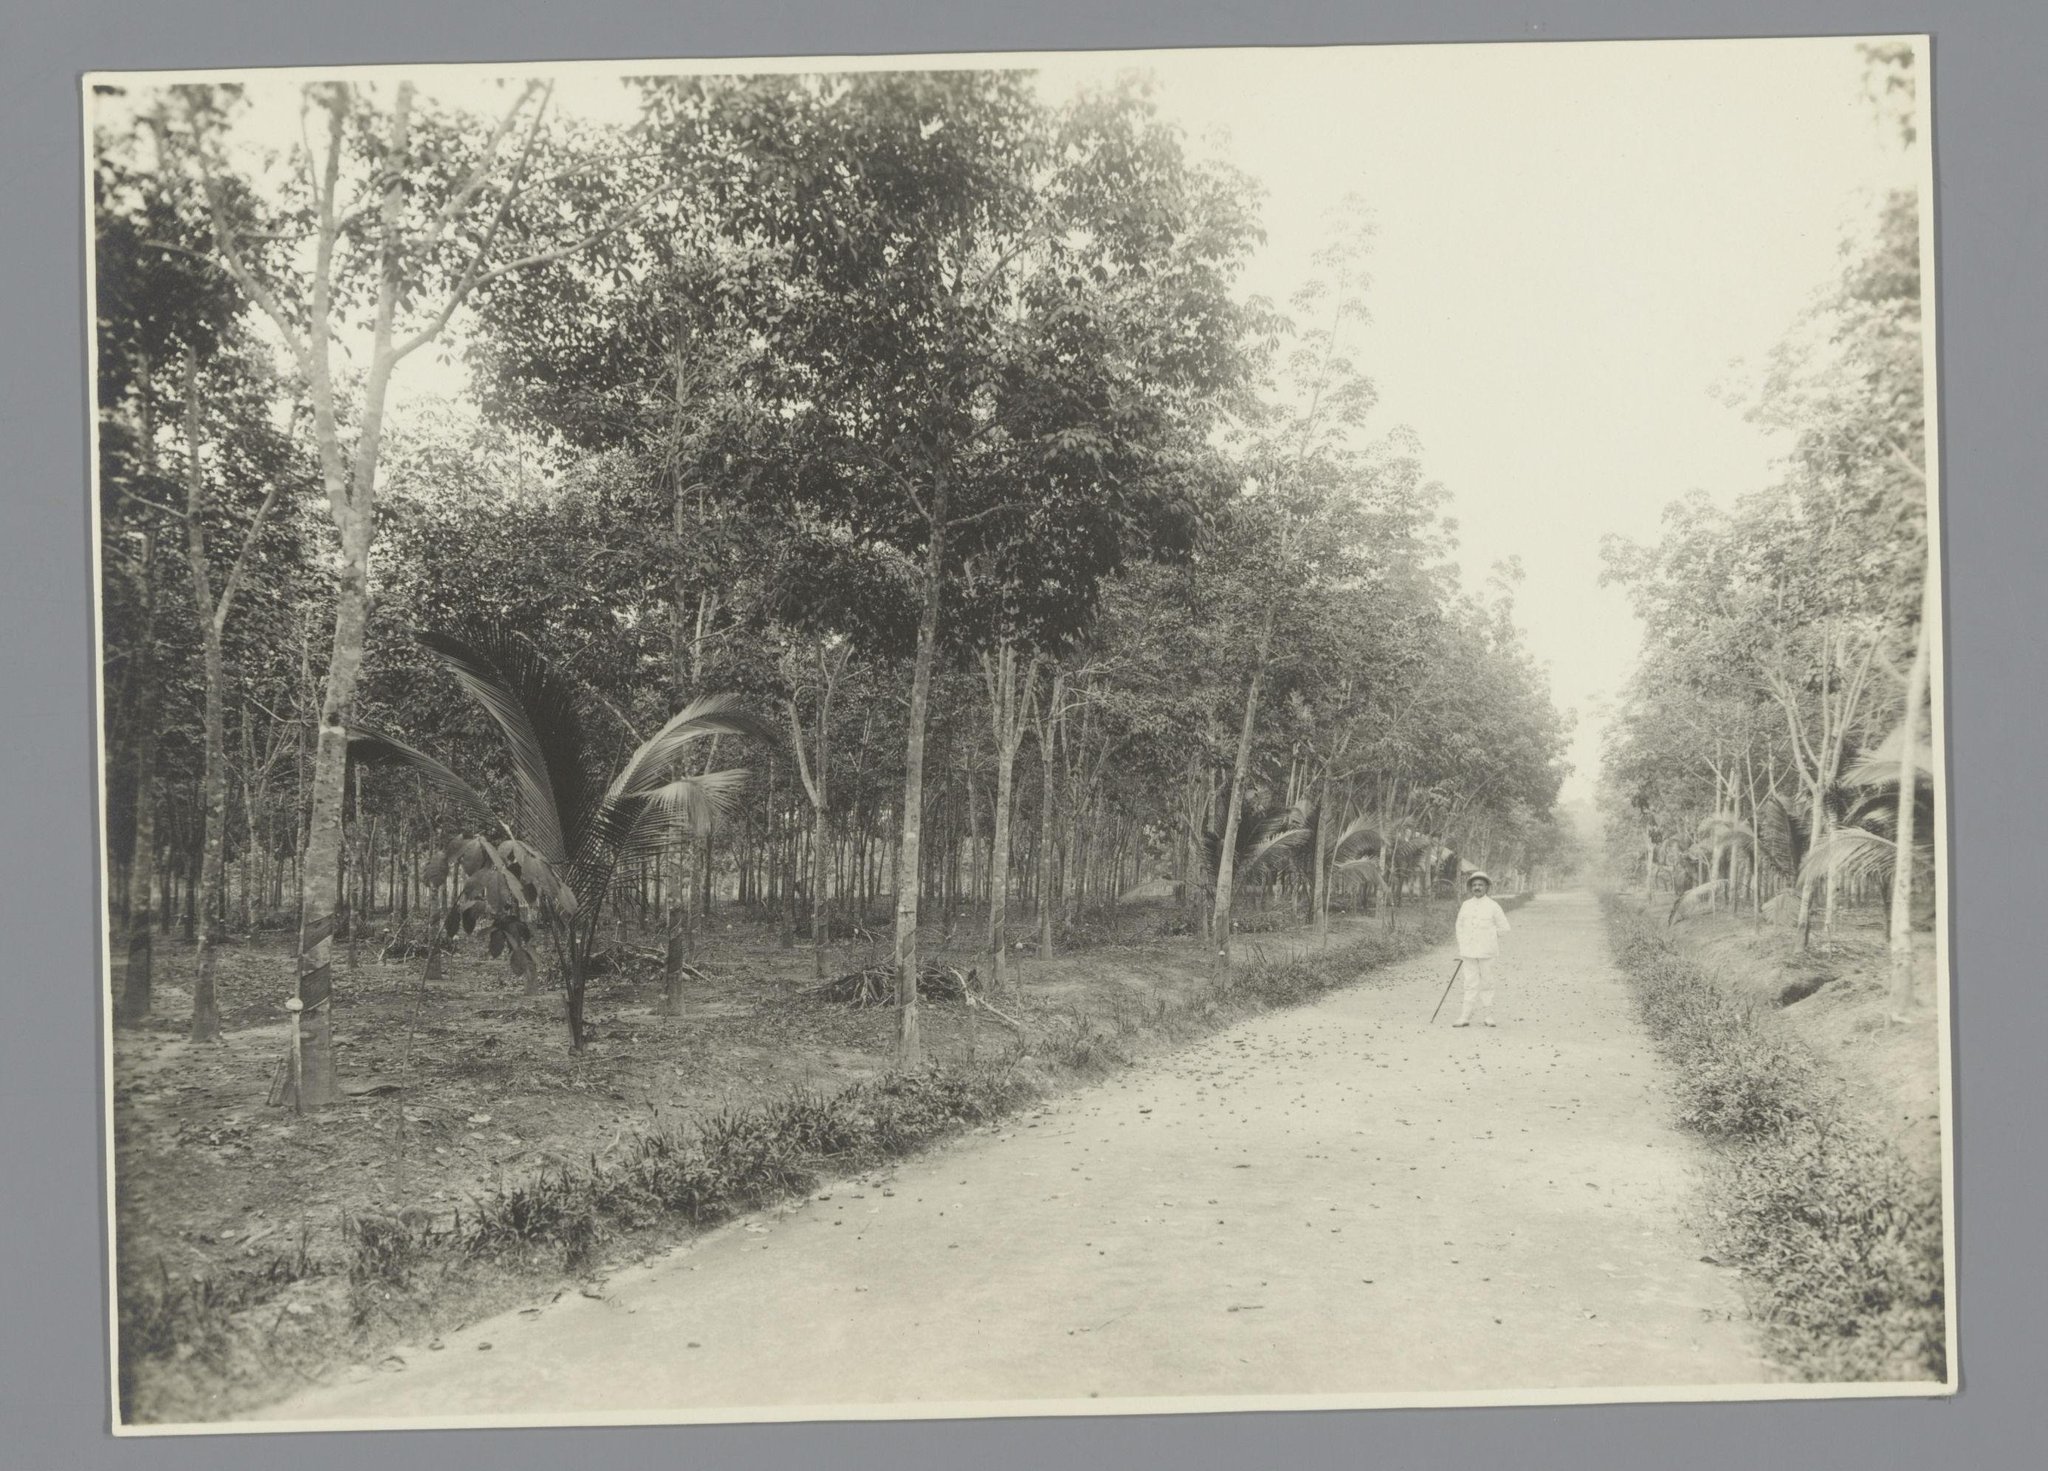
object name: photograph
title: John Bremer op de rubberplantage Boekit Pajong, Sumatra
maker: Anonymous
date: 1911-1920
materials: paper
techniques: gelatin silver print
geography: tandjong poera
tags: plantation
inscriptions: inscription: ‘24./ Boekit Pajong/ Herr J. Brauer/ links am Baum ein "Mangkuk"(=cup)/ 21.’